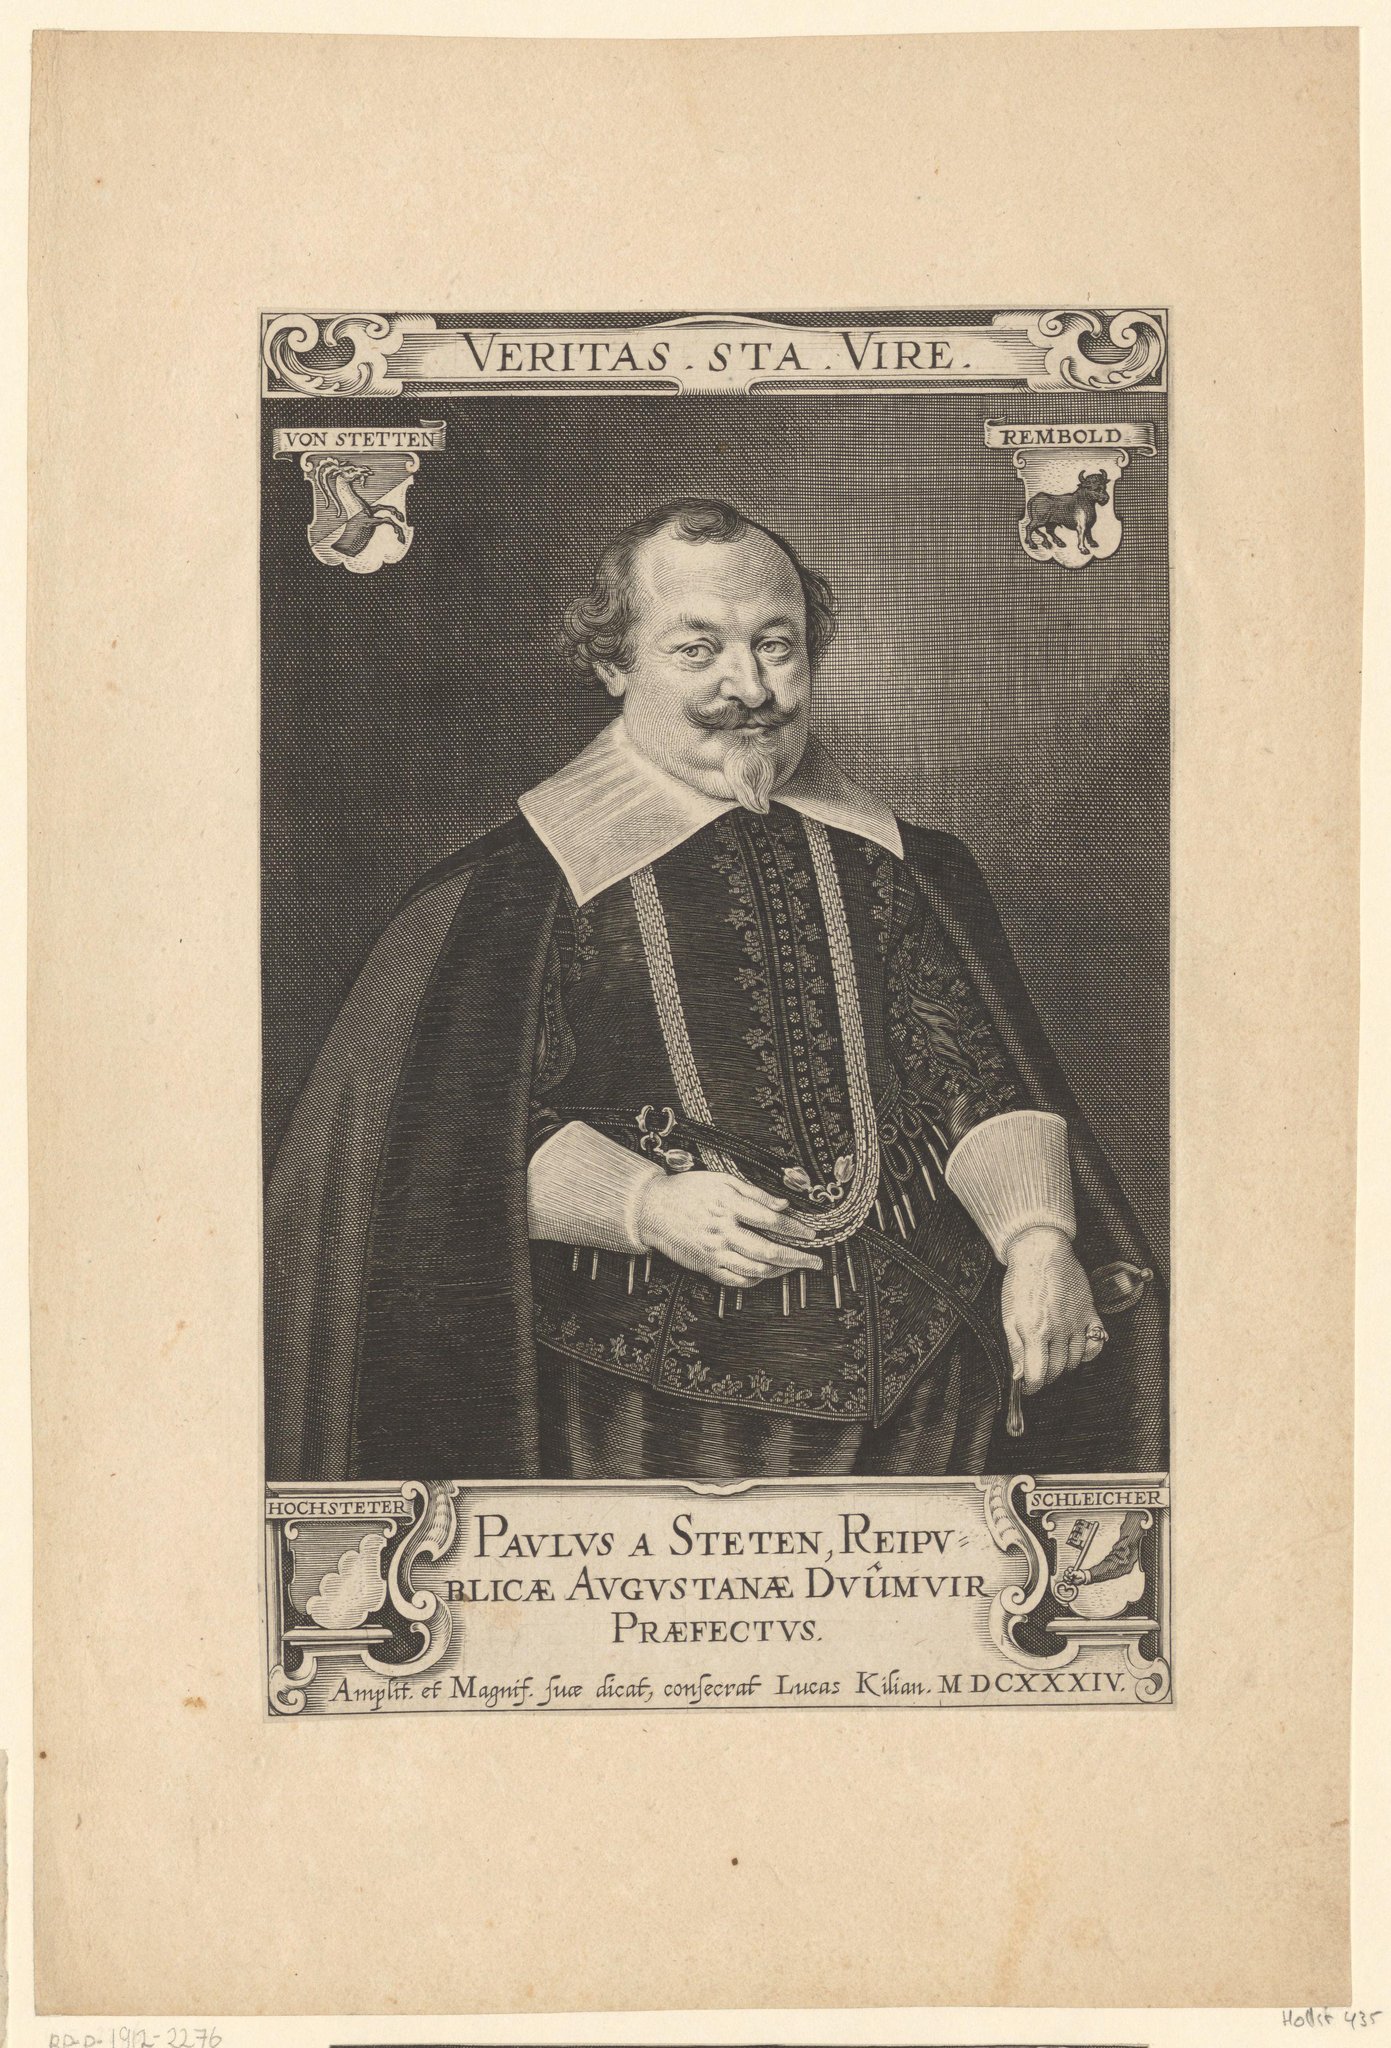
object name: print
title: Portret van Paul von Stetten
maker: lucas kilian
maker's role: draughtsman, print maker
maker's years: 1579-1637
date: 1634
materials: paper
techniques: engraving, etching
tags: mayor, burgomaster, historical persons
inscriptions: collector's mark: Lugt 2228